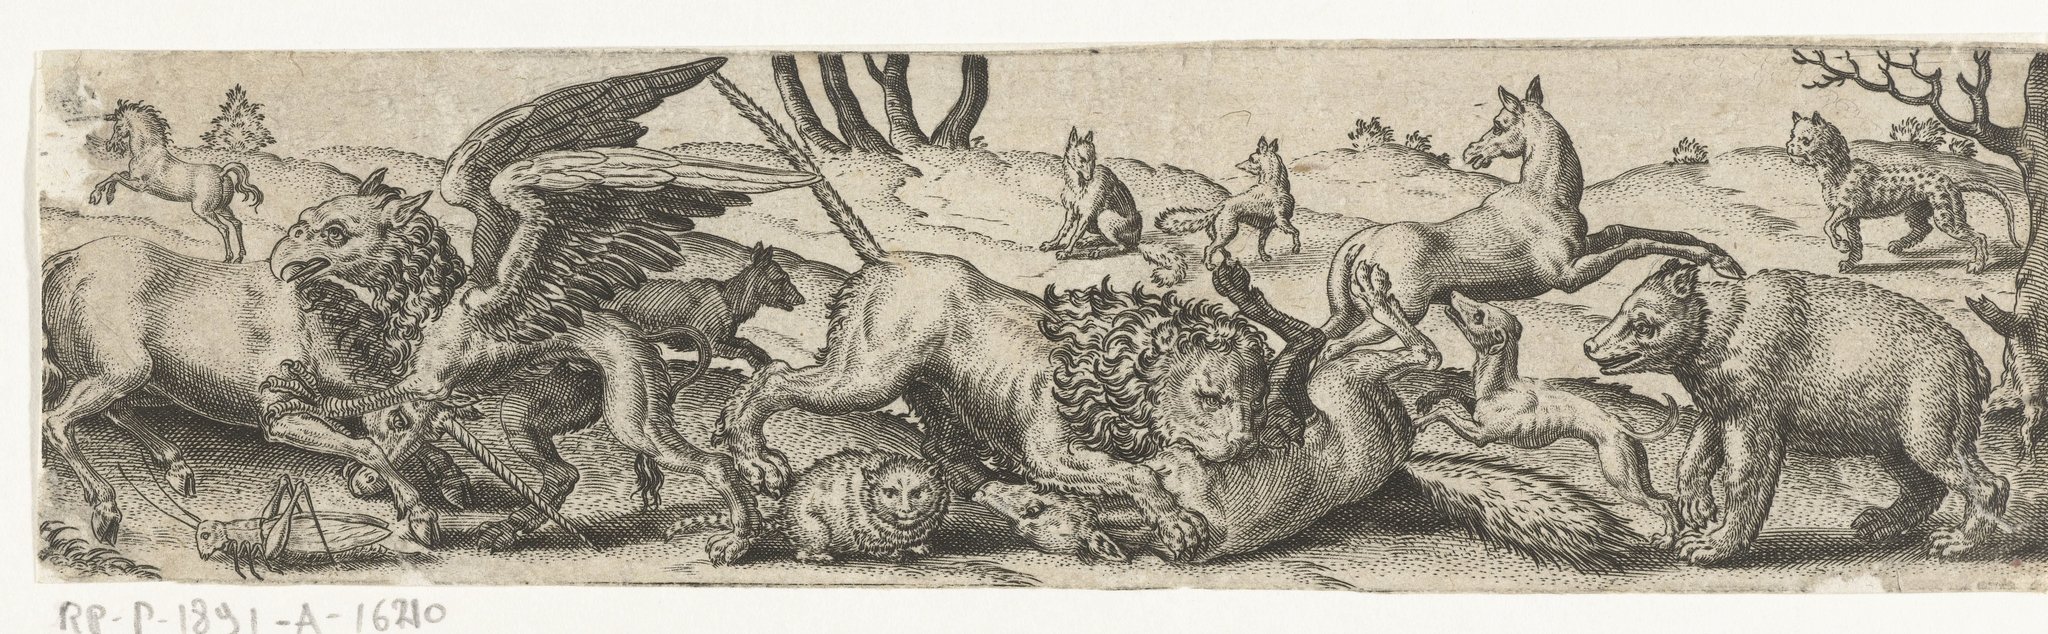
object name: print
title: Vechtende dieren in een landschap.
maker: abraham de bruyn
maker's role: print maker, publisher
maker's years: 1540-1587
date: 1579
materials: paper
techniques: engraving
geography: antwerp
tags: beasts of prey, predatory animals: leopard, griffin (lion/eagle); 'griffo' (ripa), unicorn, cat, animals (+ fighting animals; aggressive relations), horse, beasts of prey, predatory animals: lion, insects: grass-hopper, dog, beasts of prey, predatory animals: fox, beasts of prey, predatory animals: wolf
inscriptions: collector's mark: Lugt 2228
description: Een landschap vol met dieren die elkaar bevechten. Links een gevecht tussen een griffioen en een eenhoorn, in het midden een leeuw die een wolf verscheurt, rechts een beer en een hond. Andere aanwezige dieren zijn sprinkhaan, kat, vos, paard en luipaard.